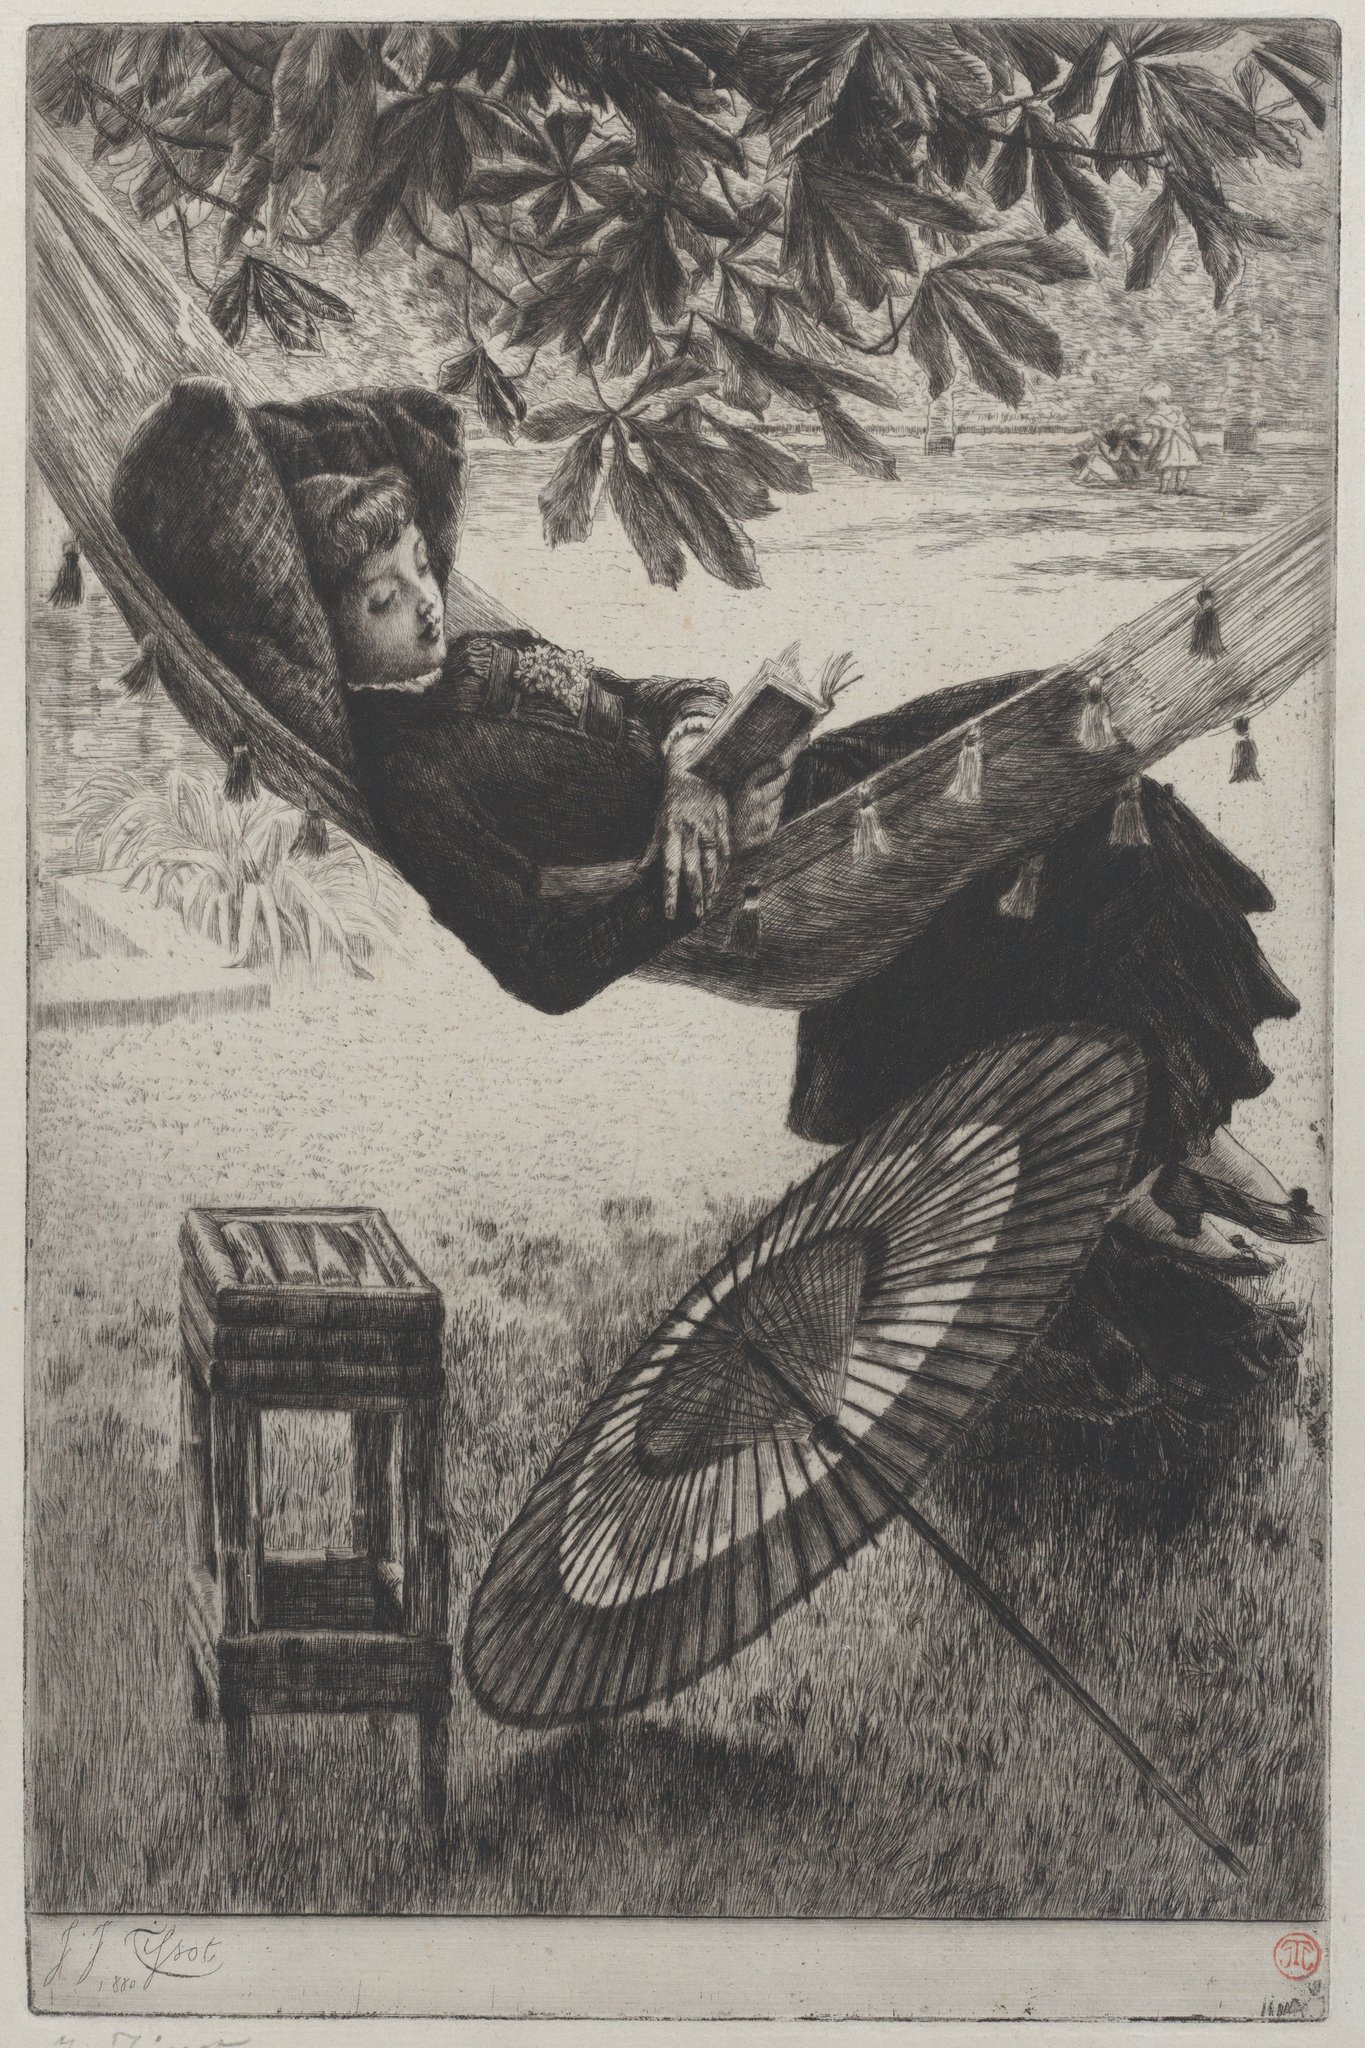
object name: print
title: The Hammock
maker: james tissot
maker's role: artist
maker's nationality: french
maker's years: 1836-1902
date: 1880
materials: paper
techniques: drypoint, etching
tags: women,reading,parasols